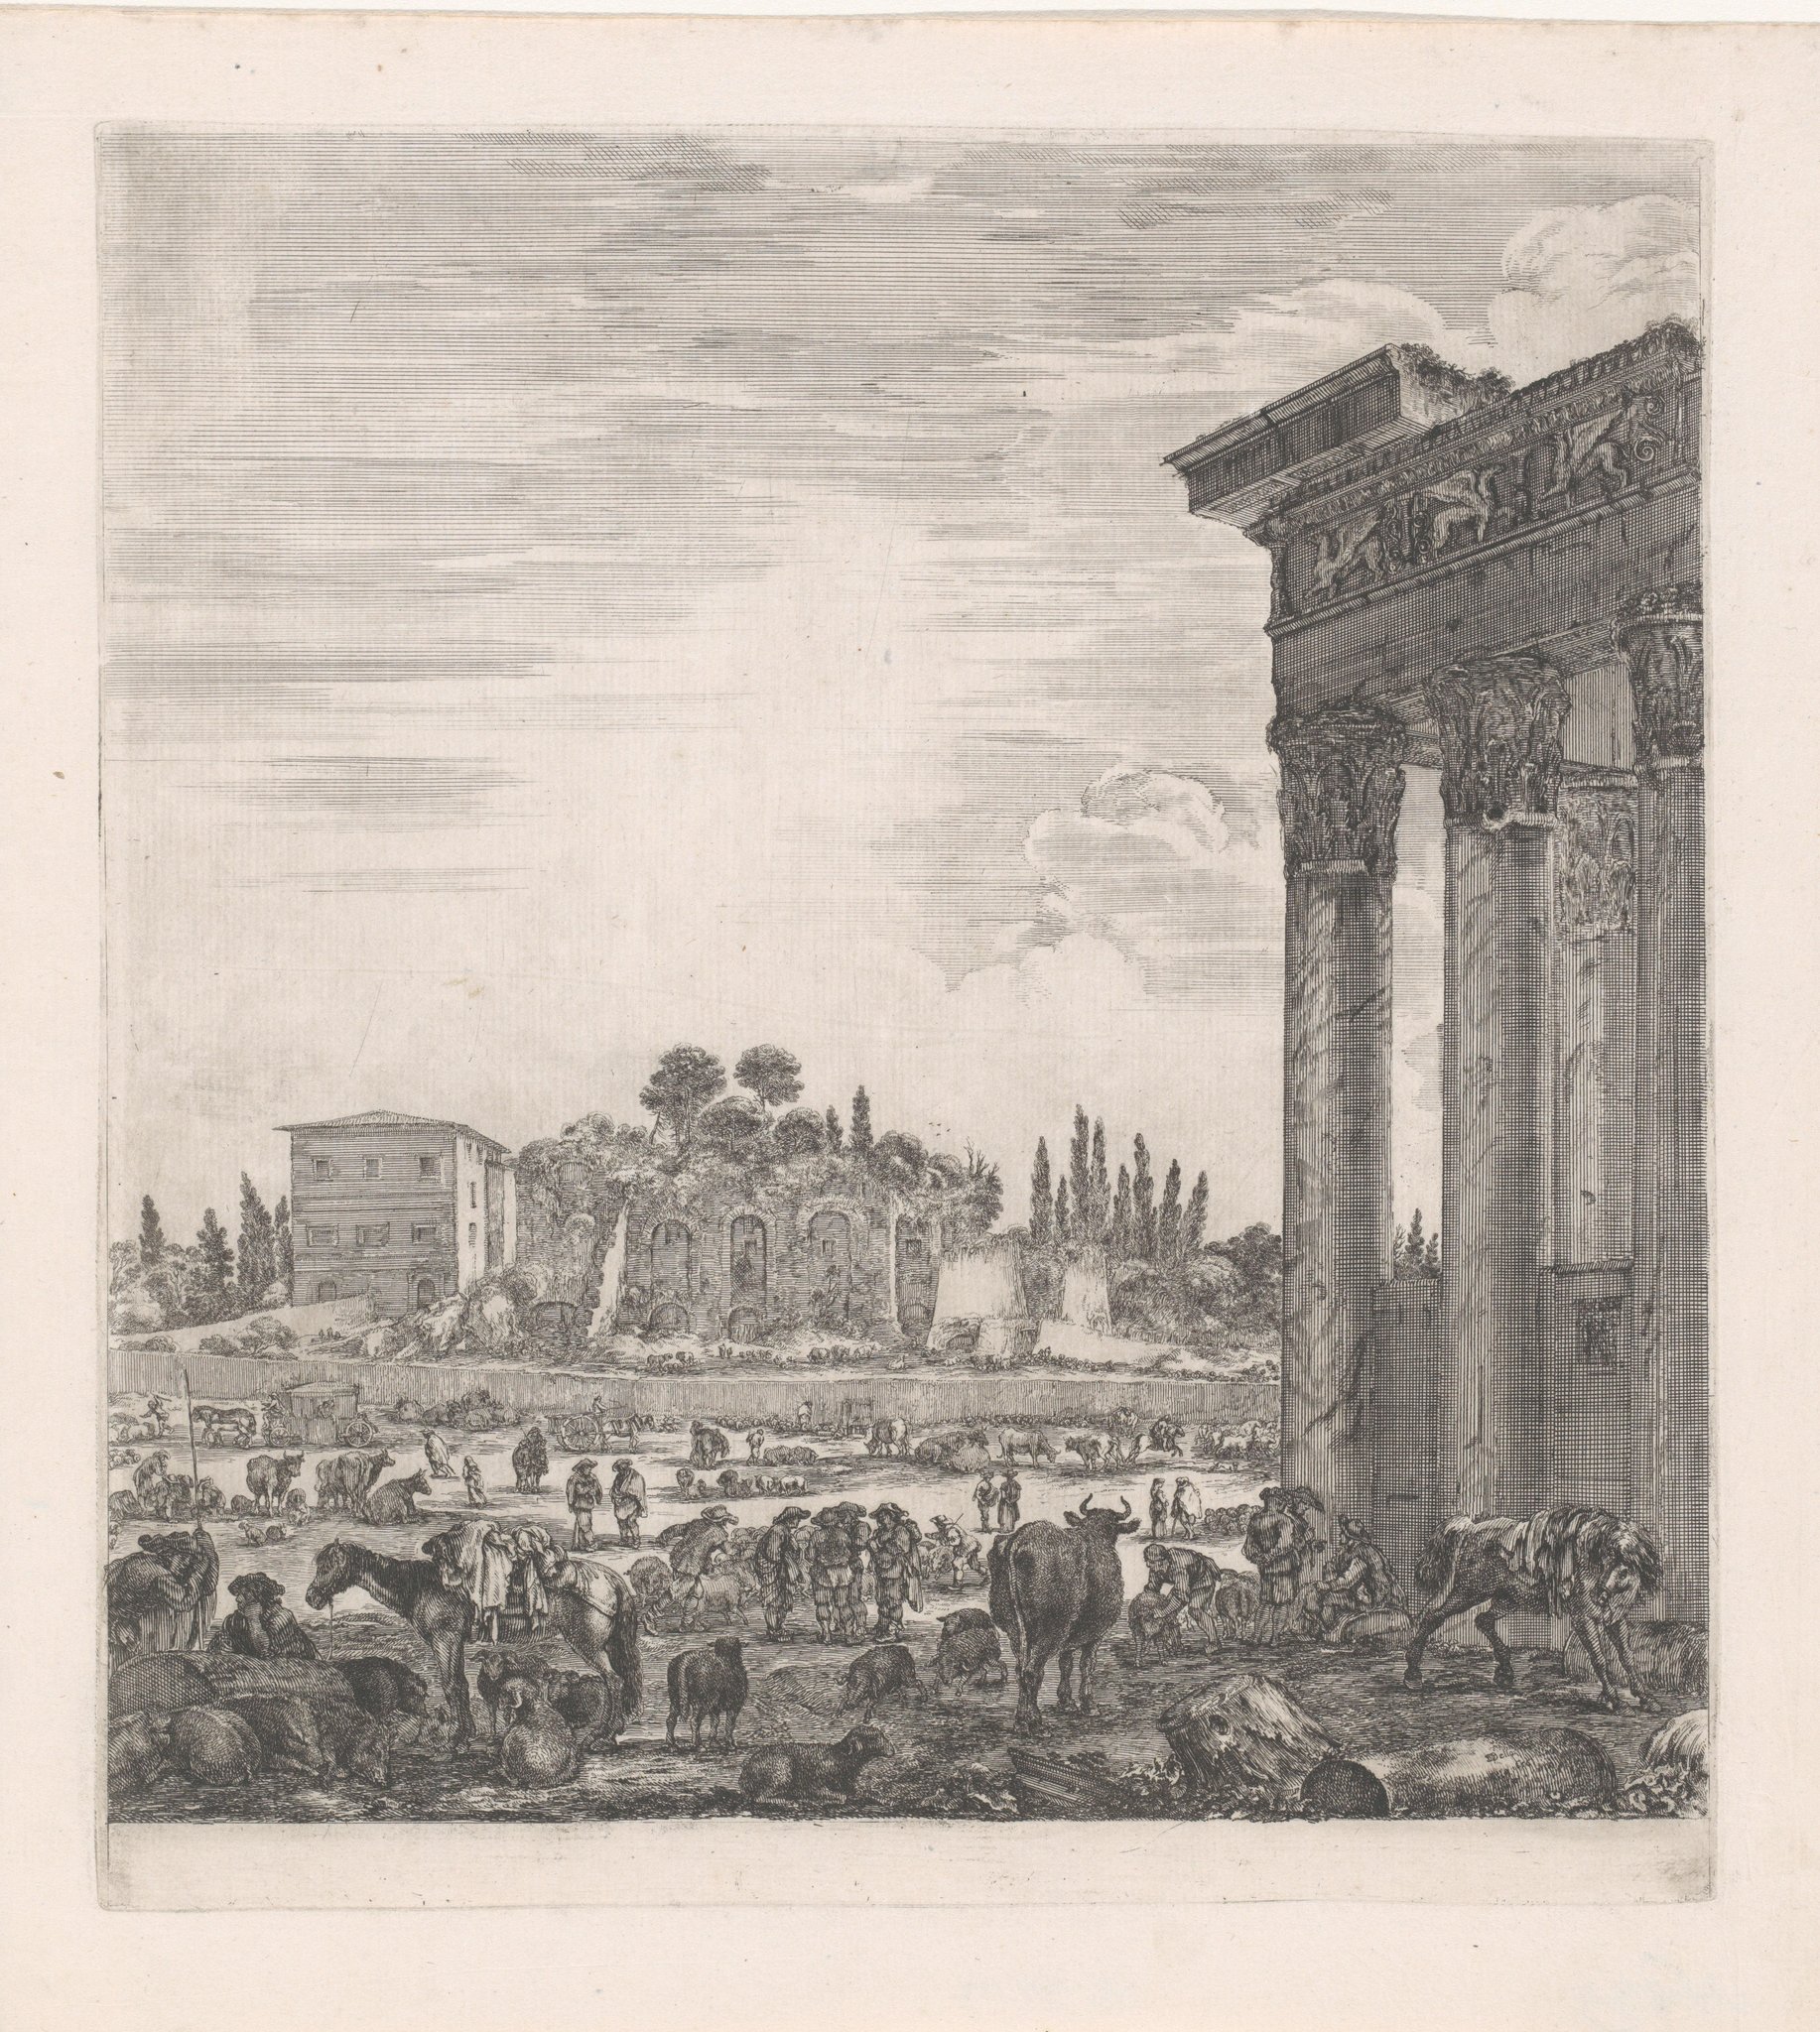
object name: print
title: Six grandes vues, dont quatre de Rome et deux de la Campagne romaine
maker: stefano della bella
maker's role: draughtsman, print maker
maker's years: 1610-1664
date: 1620-1664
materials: paper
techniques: etching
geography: italy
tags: herding, herdsman, herdswoman, shepherd, shepherdess, cowherd, etc., ruin of a building ~ architecture, herd, flock, rome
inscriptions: collector's mark: Lugt 240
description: Prent uit een reeks van zes prenten. Getekende voorstudies worden bewaard in het Musée du Louvre te Parijs (inv. nr. 315-3, album p. 16) en in de Biblioteca Marucelliana te Florence (Vol. D, N. 112).